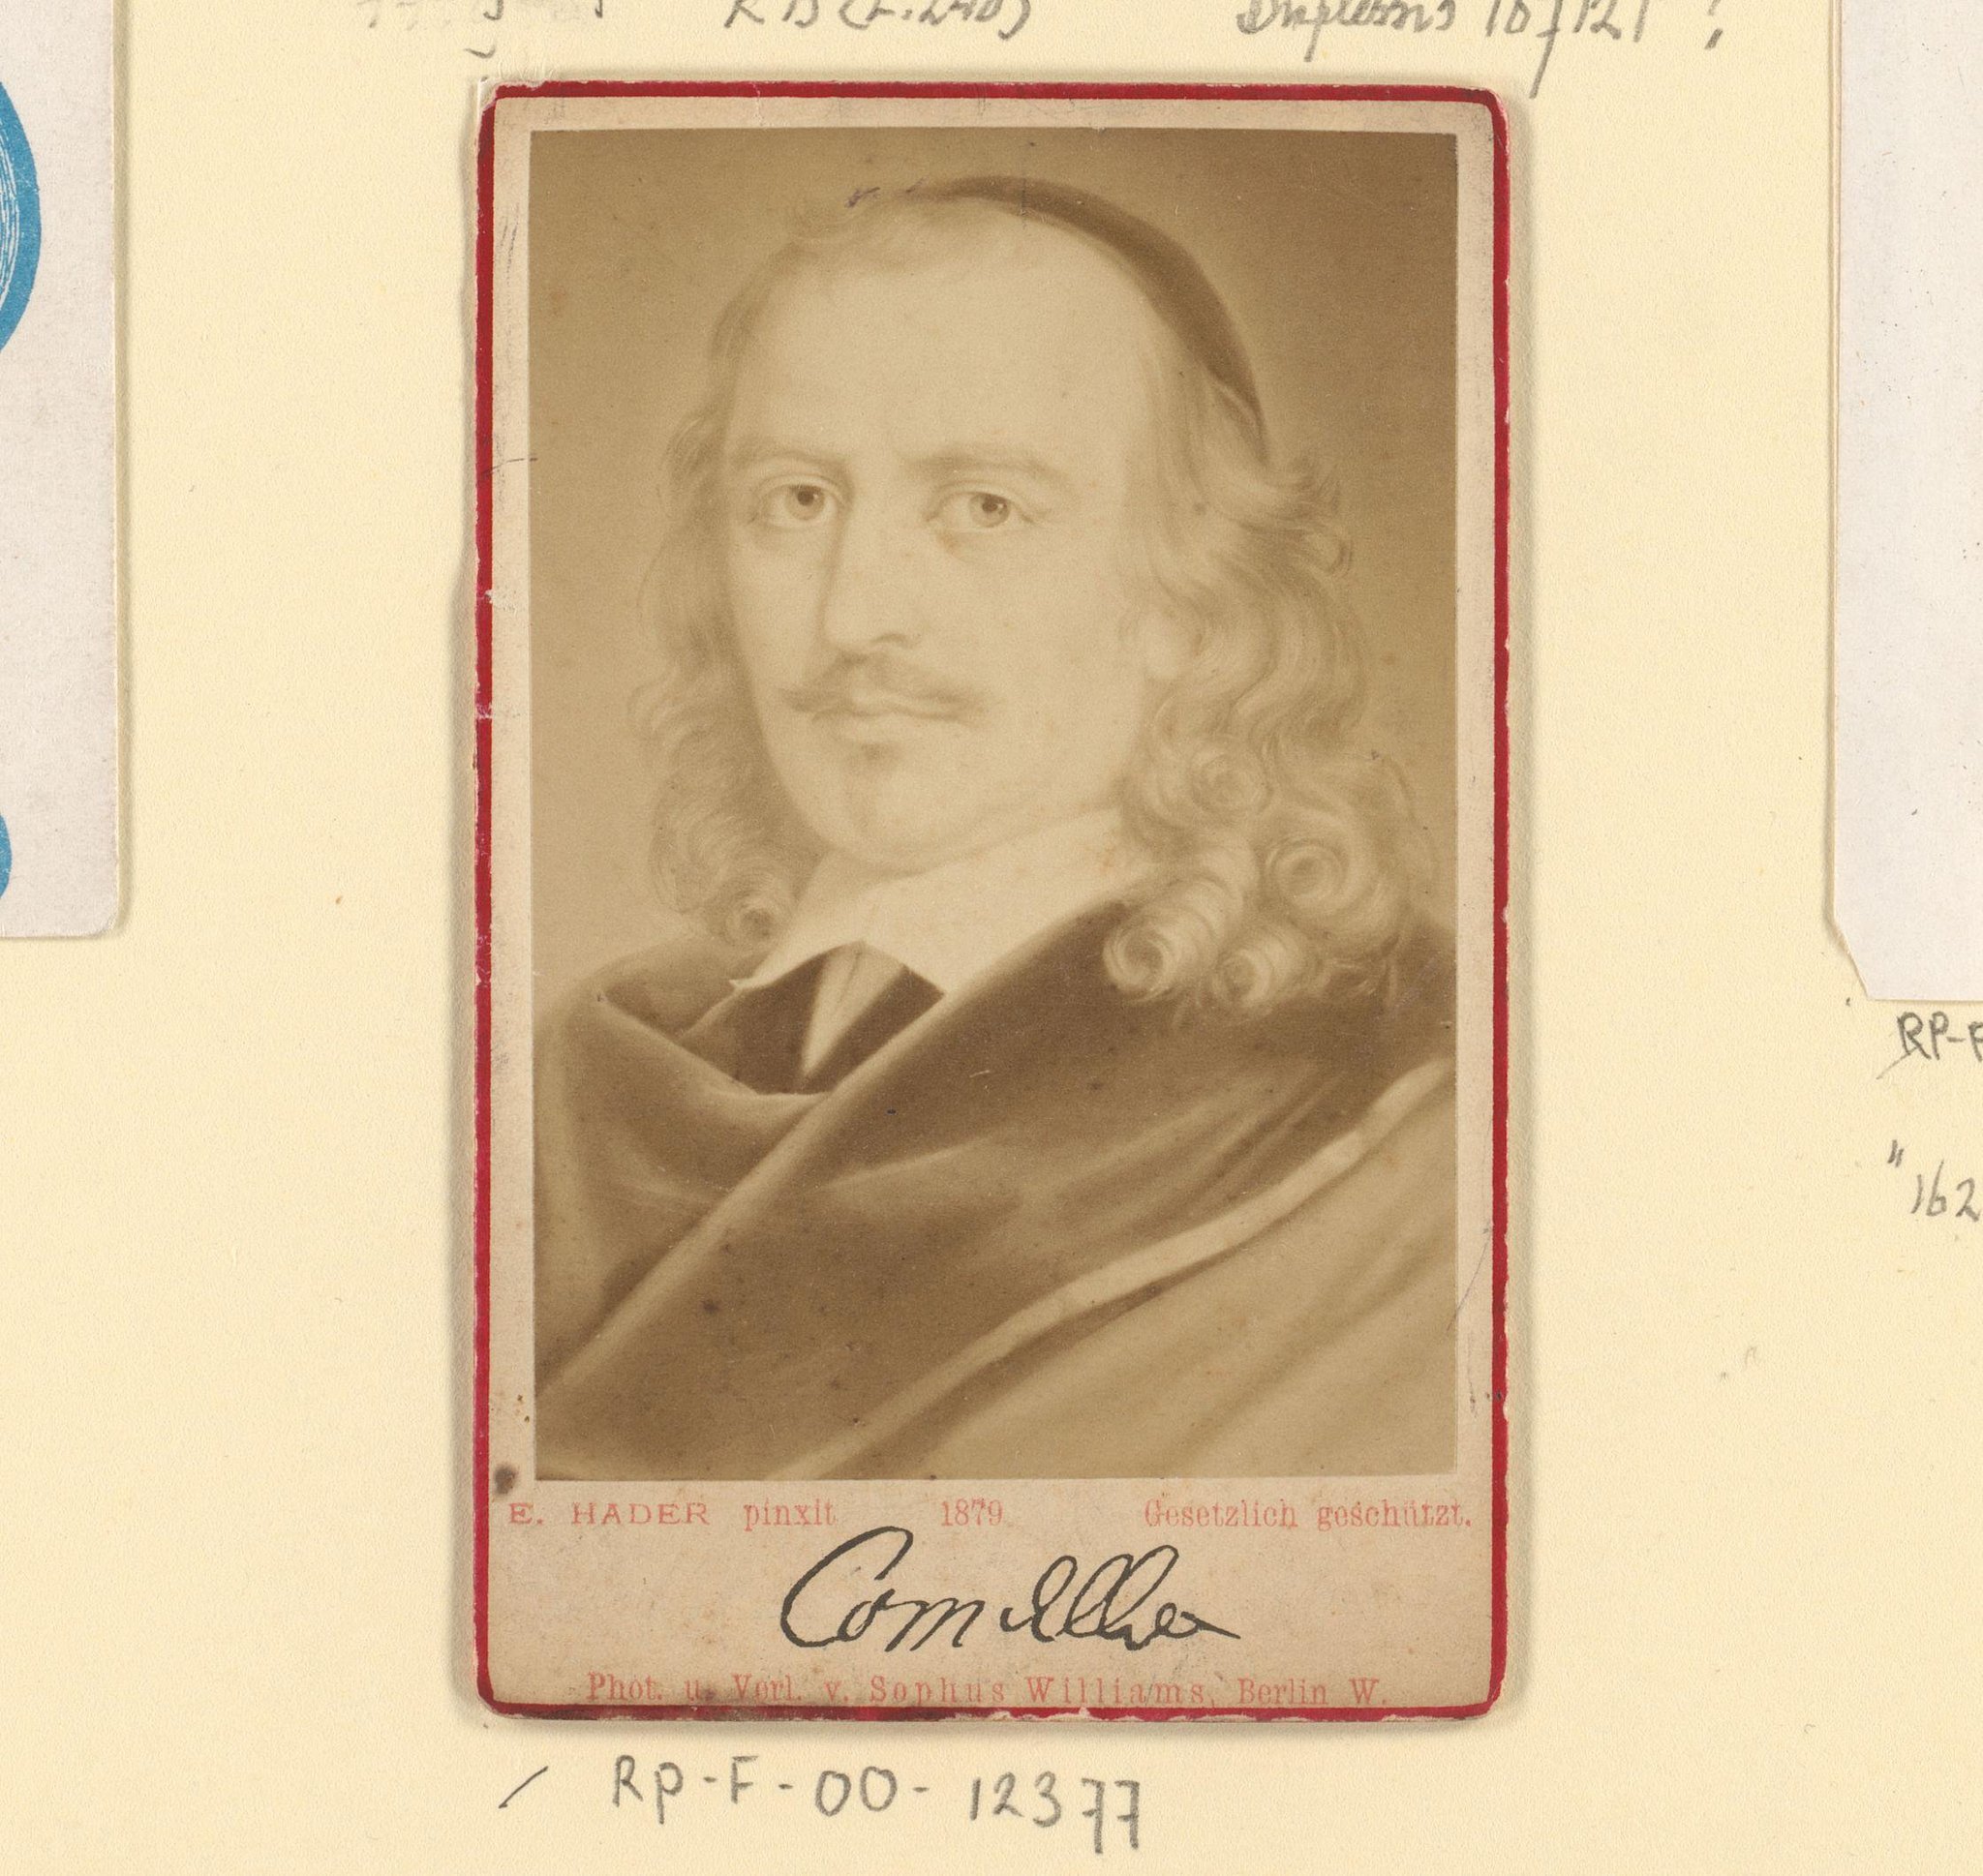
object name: carte de visite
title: Fotoreproductie van een geschilderd portret van Pierre Corneille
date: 1879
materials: cardboard, paper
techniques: albumen print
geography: berlin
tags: pierre corneille, historical persons, portrait of a writer, picture, painting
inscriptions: inscription: ‘Gesetzlich geschützt.’, inscription: ‘Corneille’